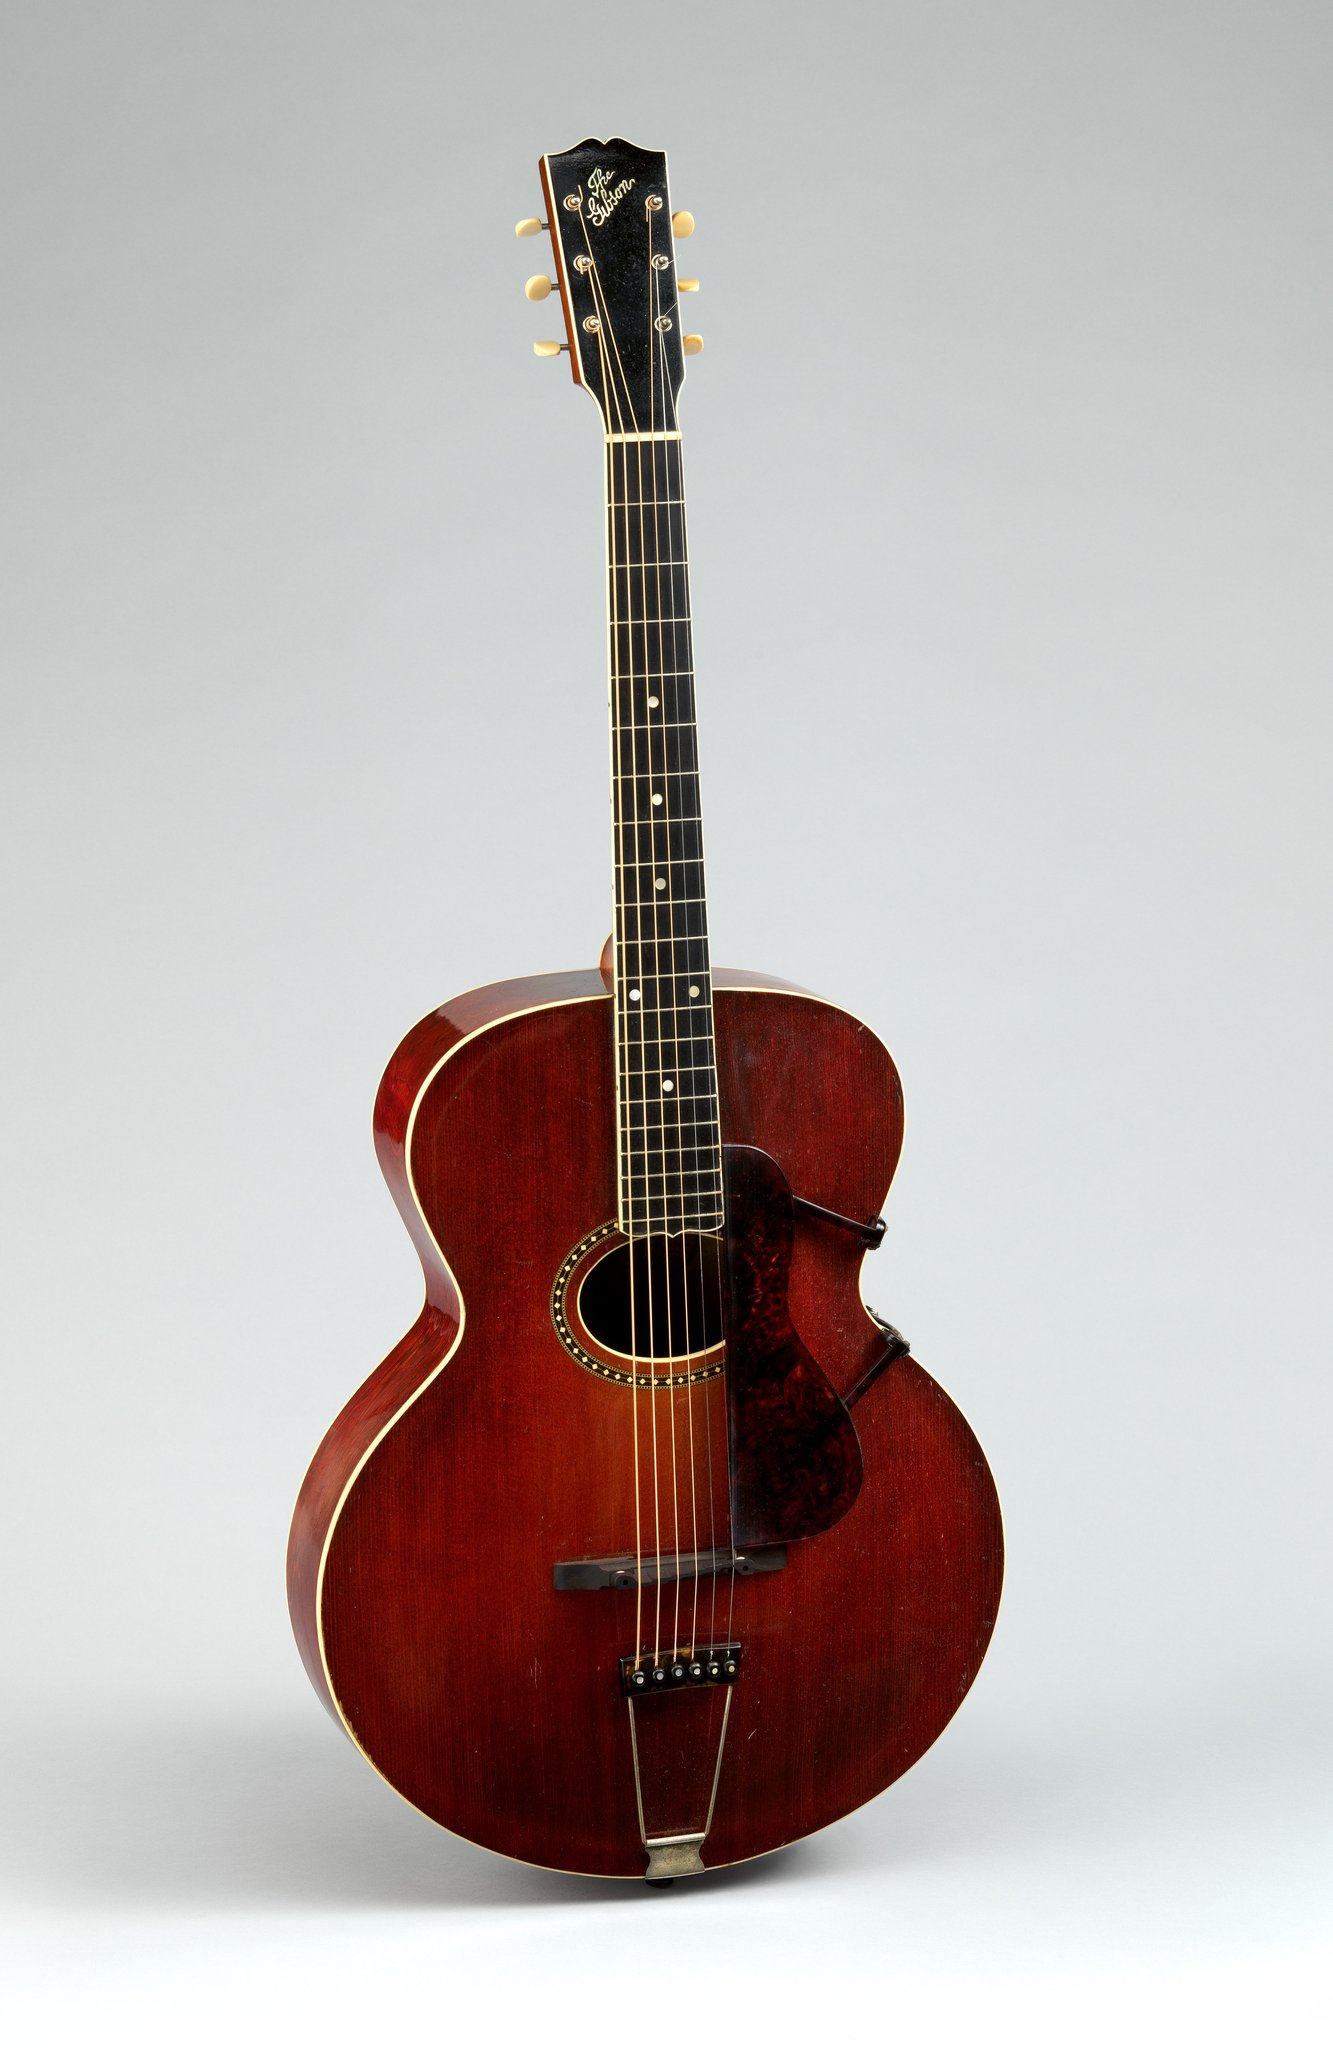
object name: archtop guitar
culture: american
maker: gibson mandolin-guitar manufacturing co., ltd.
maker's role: maker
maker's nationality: american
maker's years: 1902-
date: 1918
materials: wood, mother of pearl, nickel, silver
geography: united states